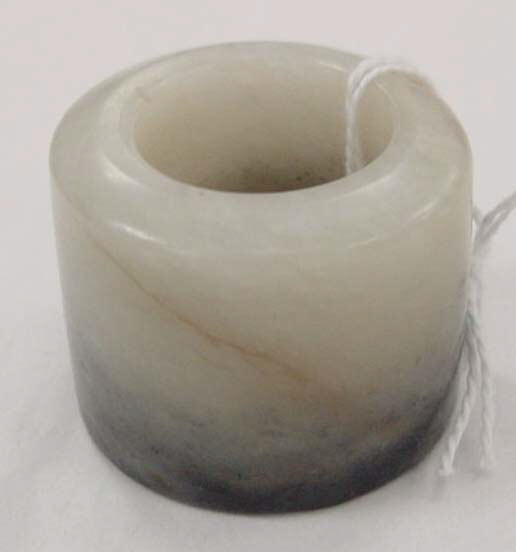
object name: ring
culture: chinese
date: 1801-1900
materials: jade